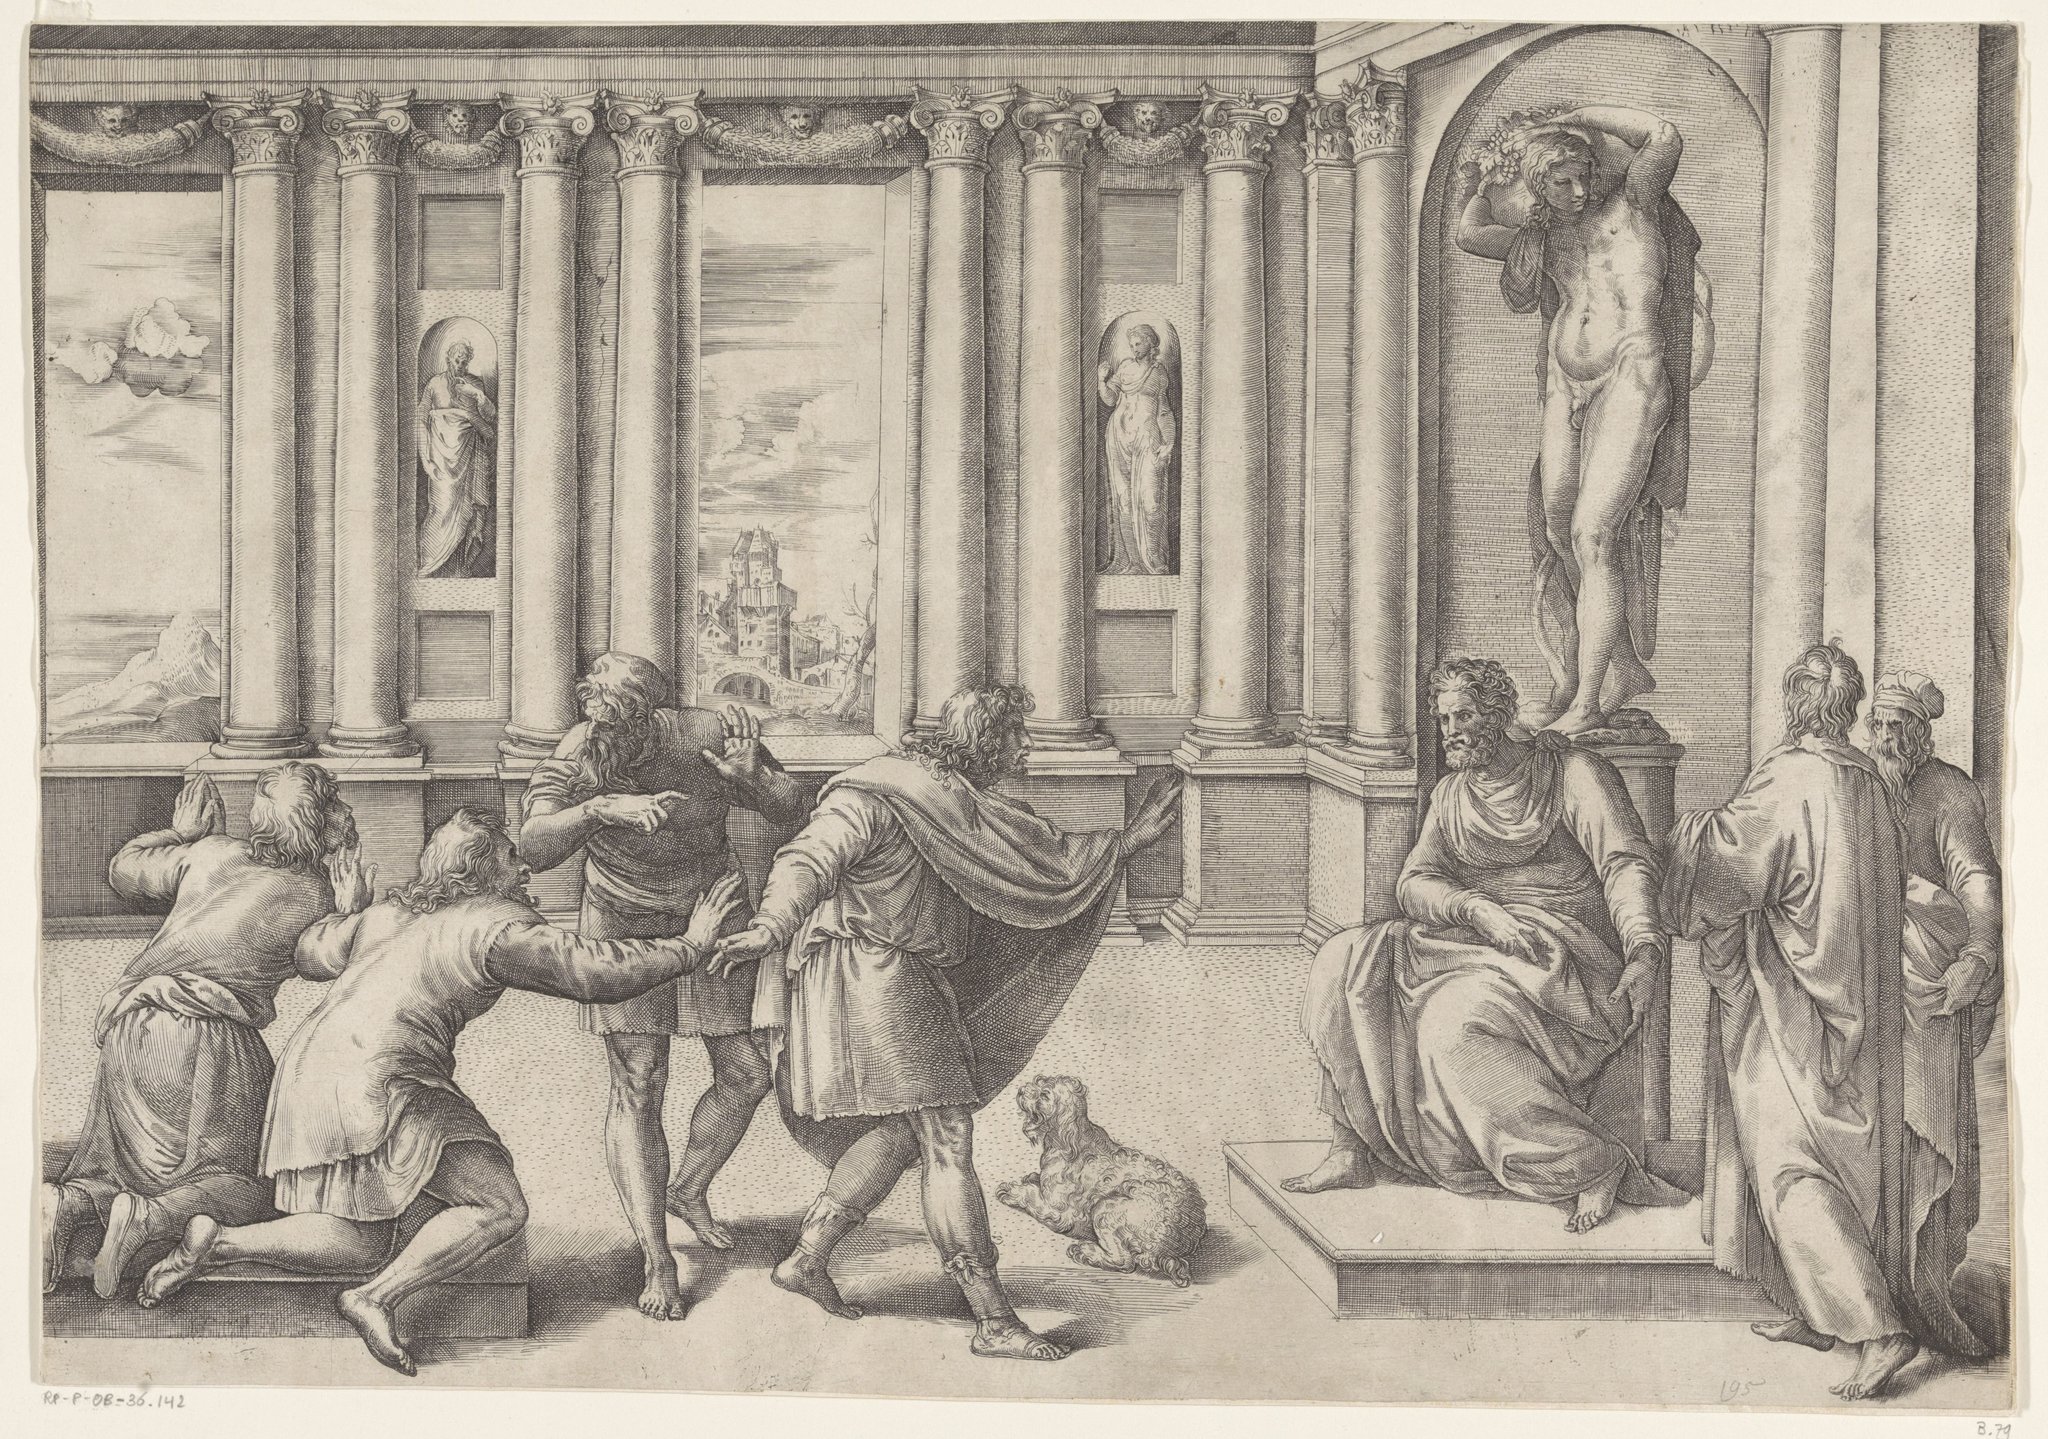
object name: print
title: Mannen op audiëntie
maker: battista franco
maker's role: draughtsman, painter, print maker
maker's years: 1510-1561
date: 1520-1561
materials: paper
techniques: engraving, etching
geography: italy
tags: audition; ruler giving audience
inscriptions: collector's mark: Lugt 240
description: Zicht in een paleiszaal met een man, zittend voor een beeld van de wijngod Bacchus. Voor de man een groep van vier mannen op audiëntie en een hond.